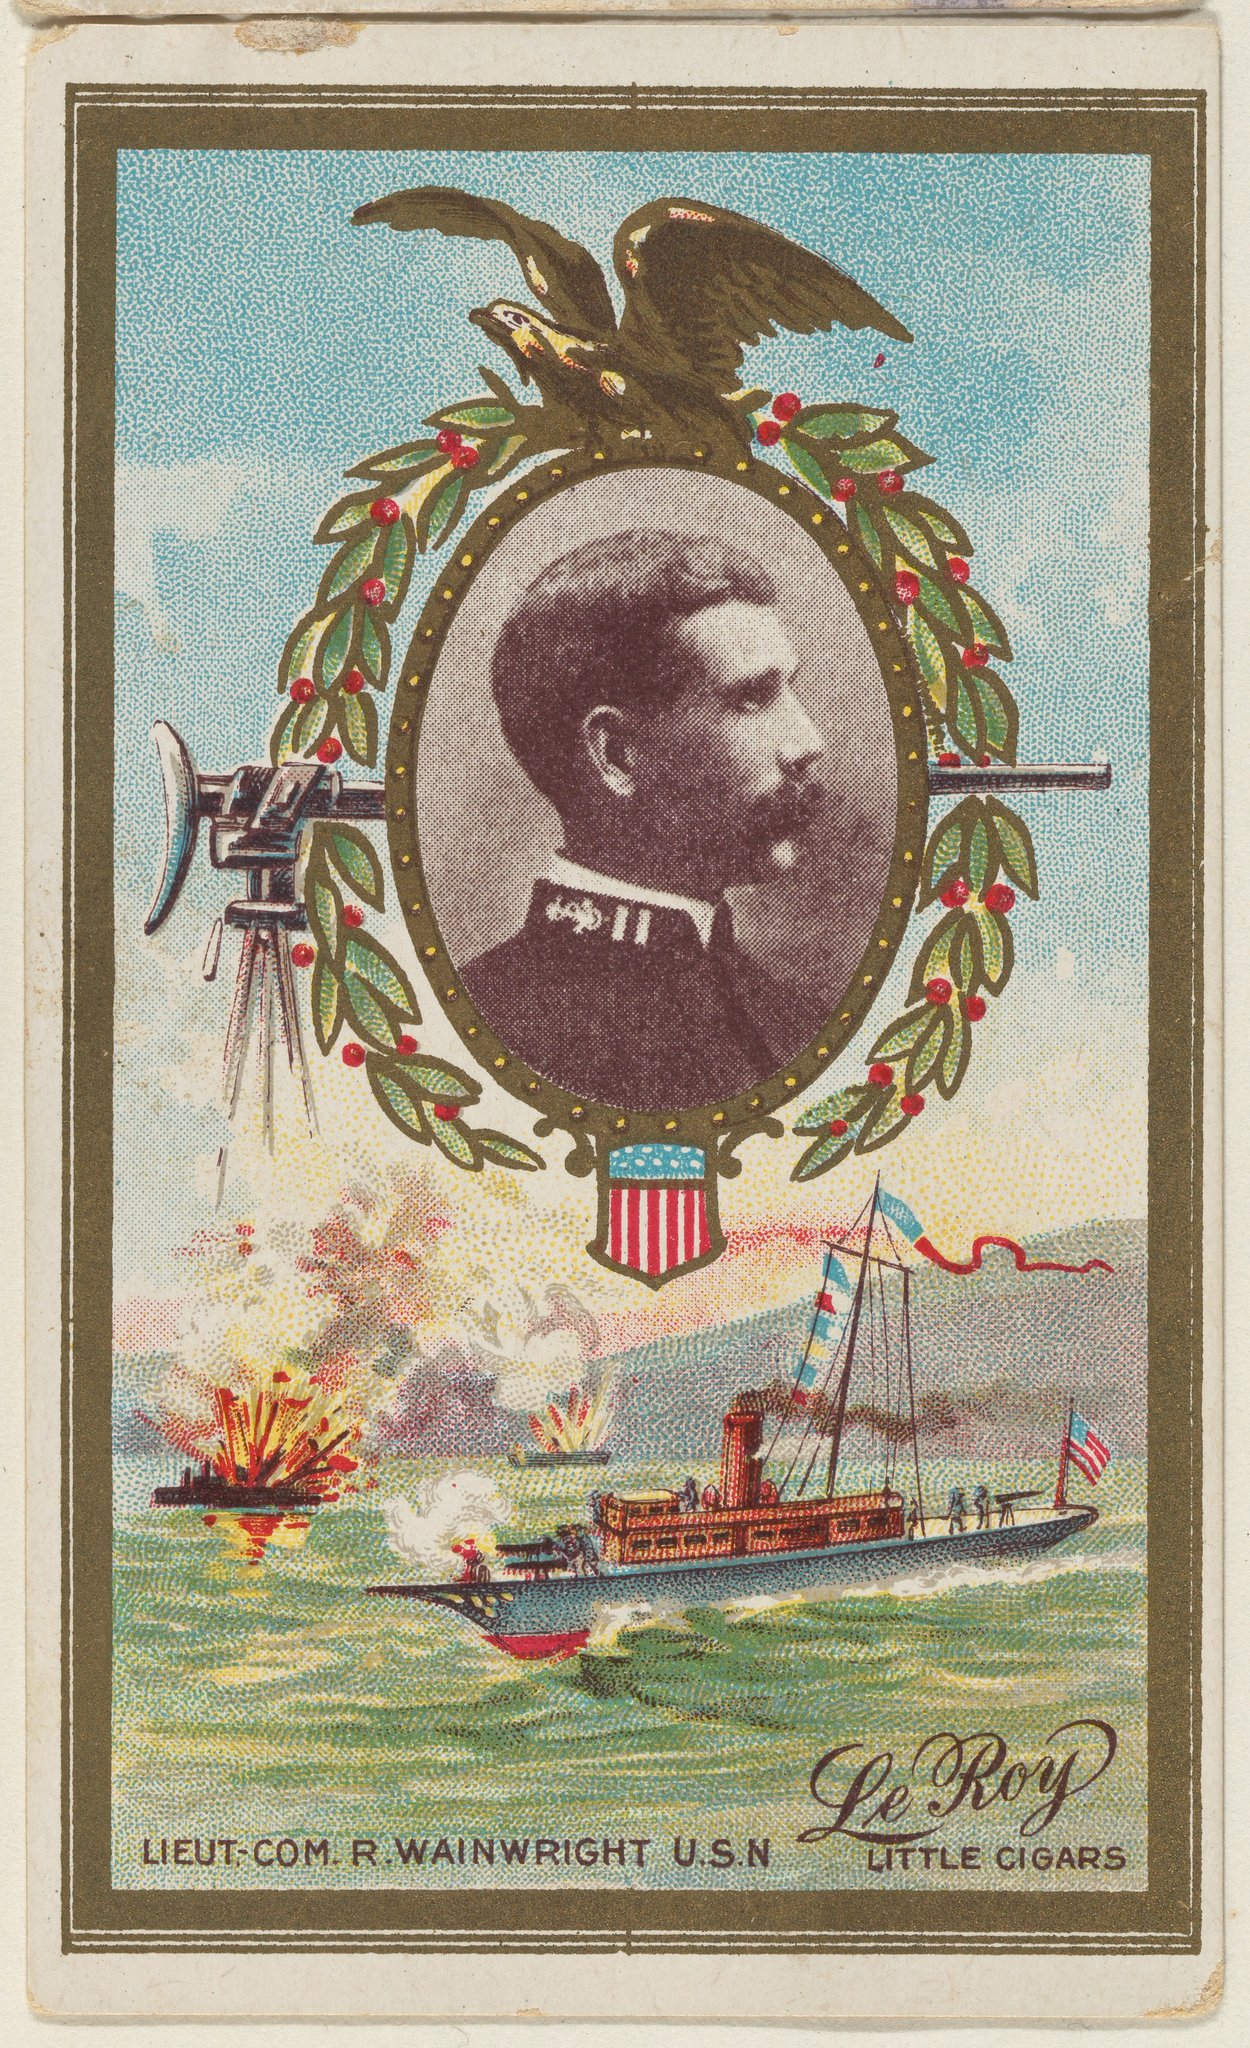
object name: print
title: Lieutenant Commander Richard Wainwright, U.S. Navy, from the "Generals" series (T63), issued by LeRoy Little Cigars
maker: leroy little cigars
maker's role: publisher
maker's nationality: american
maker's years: 1850-1950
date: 1898-1901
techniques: color lithograph